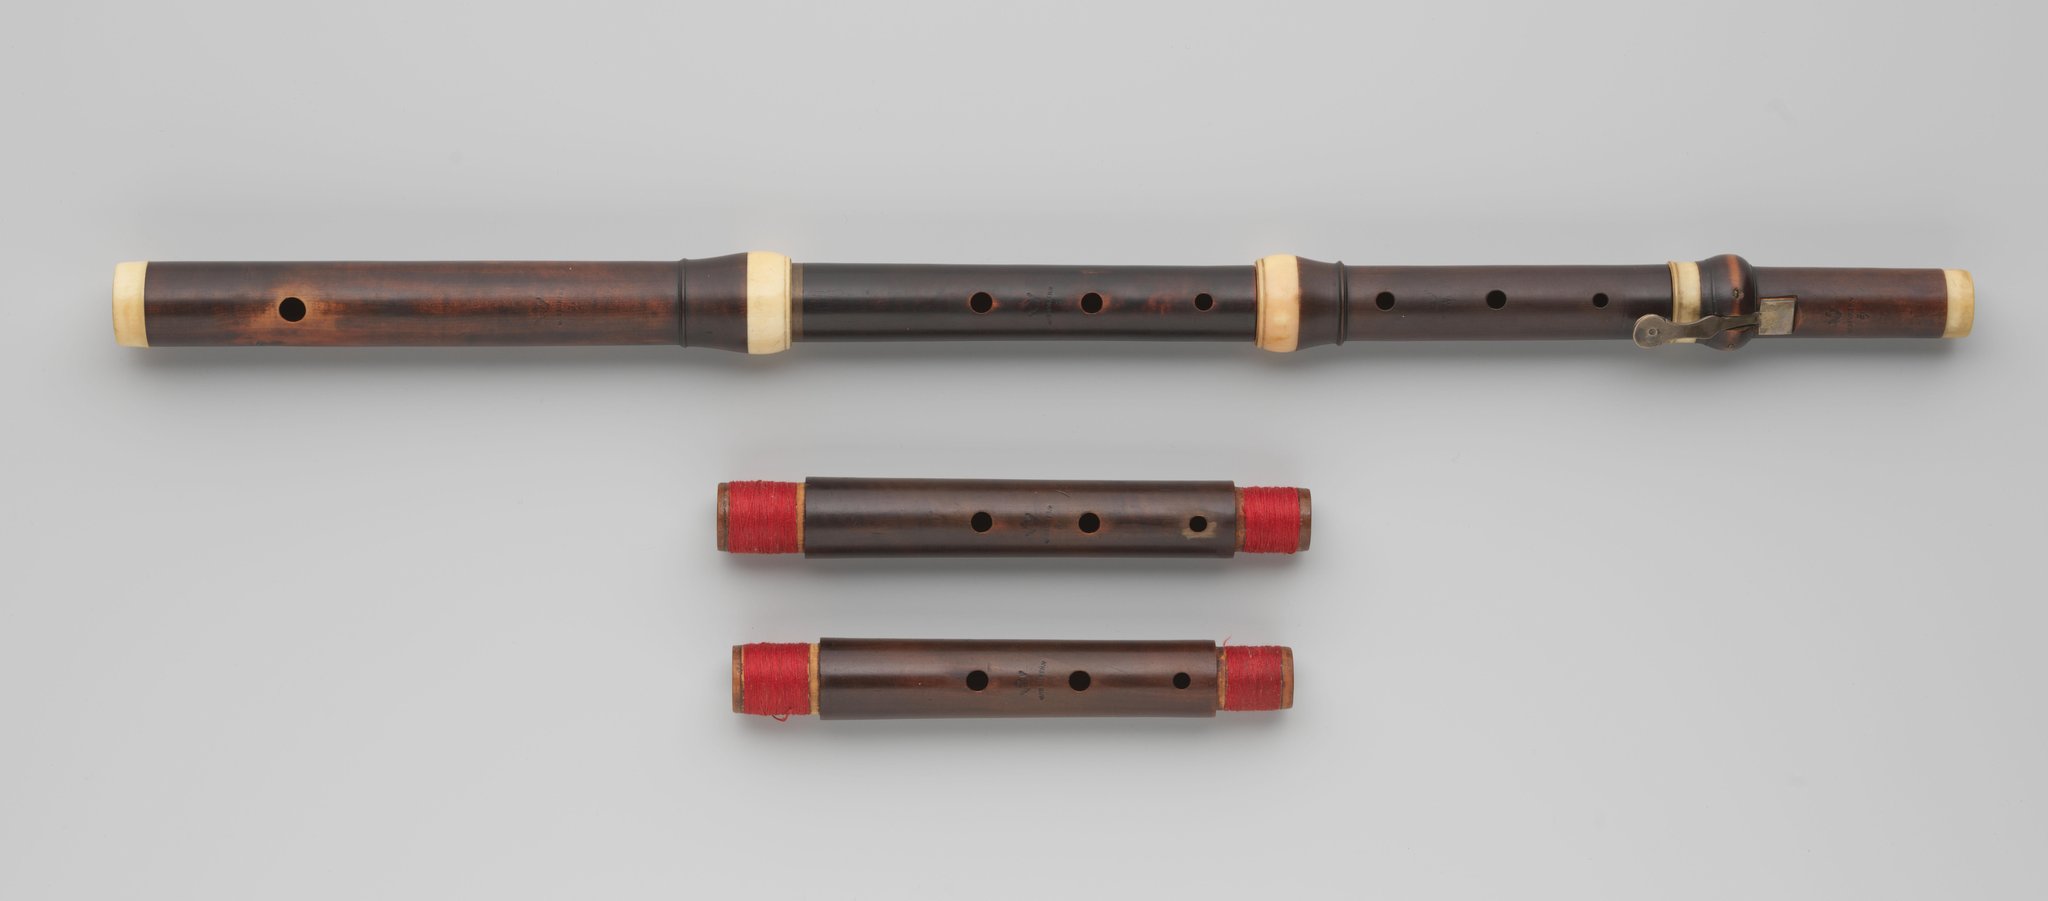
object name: wind instrument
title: Dwarsfluit met drie wisselstukken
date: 1750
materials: wood, ivory, silver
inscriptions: stamp: ‘W:BEUKERS’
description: Vierdelige dwarsfluit van donkerbruin Europees buxushout met ivoren ringen, ivoren dop en een zilver klep. De fluit heeft drie wisselstukken. Stemming a = ca. 408/415 Hz.